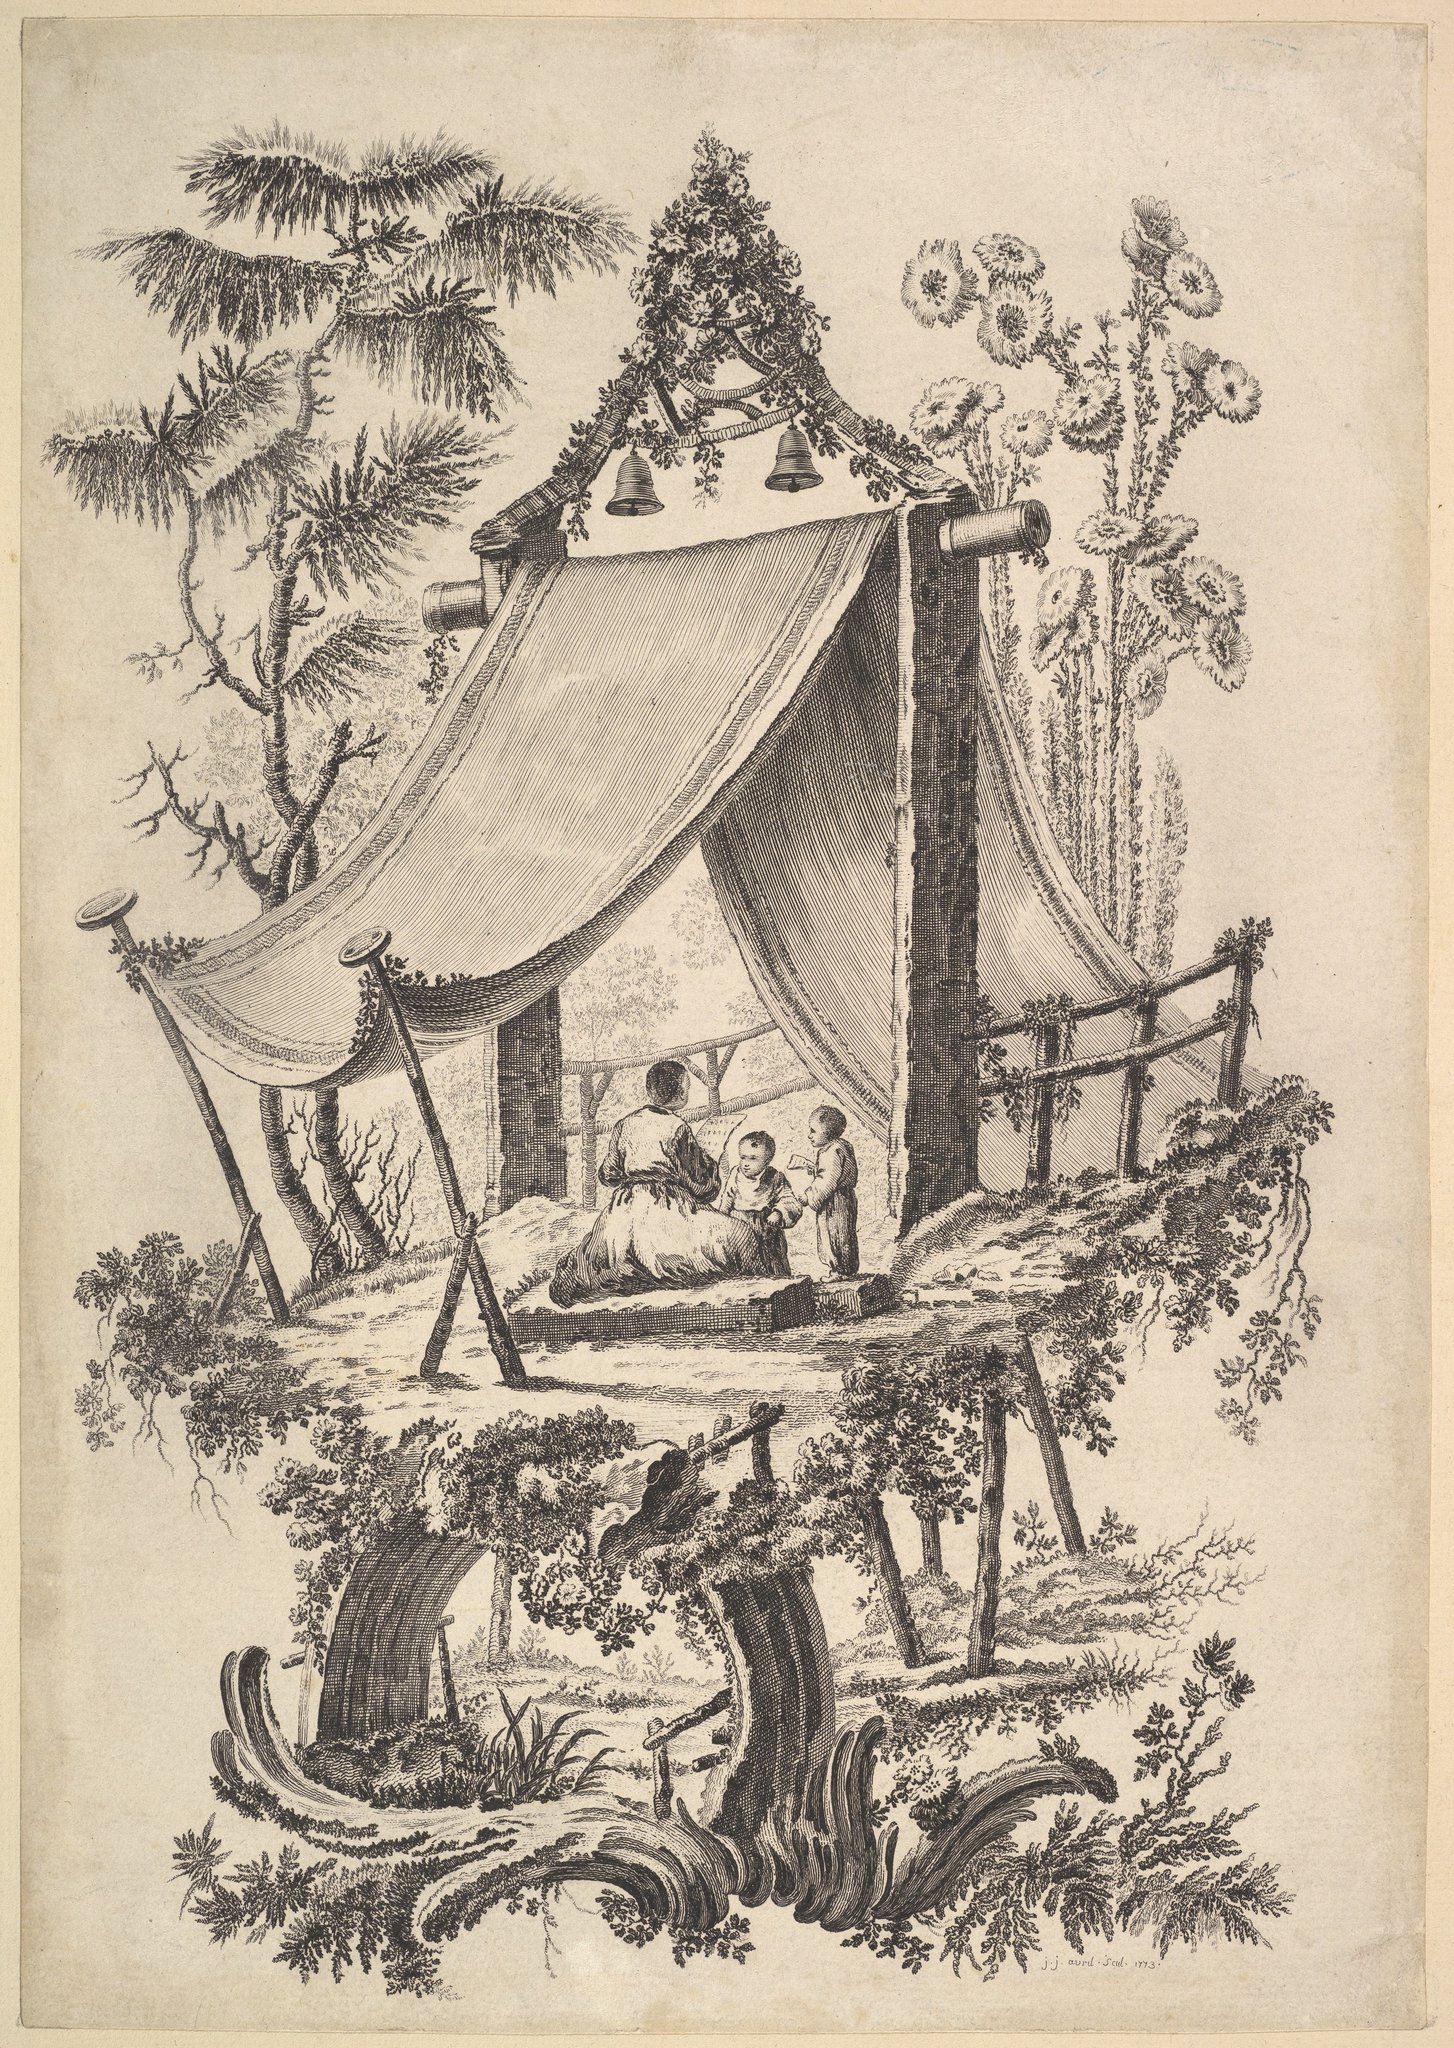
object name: print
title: Treehouse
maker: jean jacques avril, the elder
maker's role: artist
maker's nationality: french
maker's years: 1744-1831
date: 1773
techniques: etching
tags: tents,children,women,trees